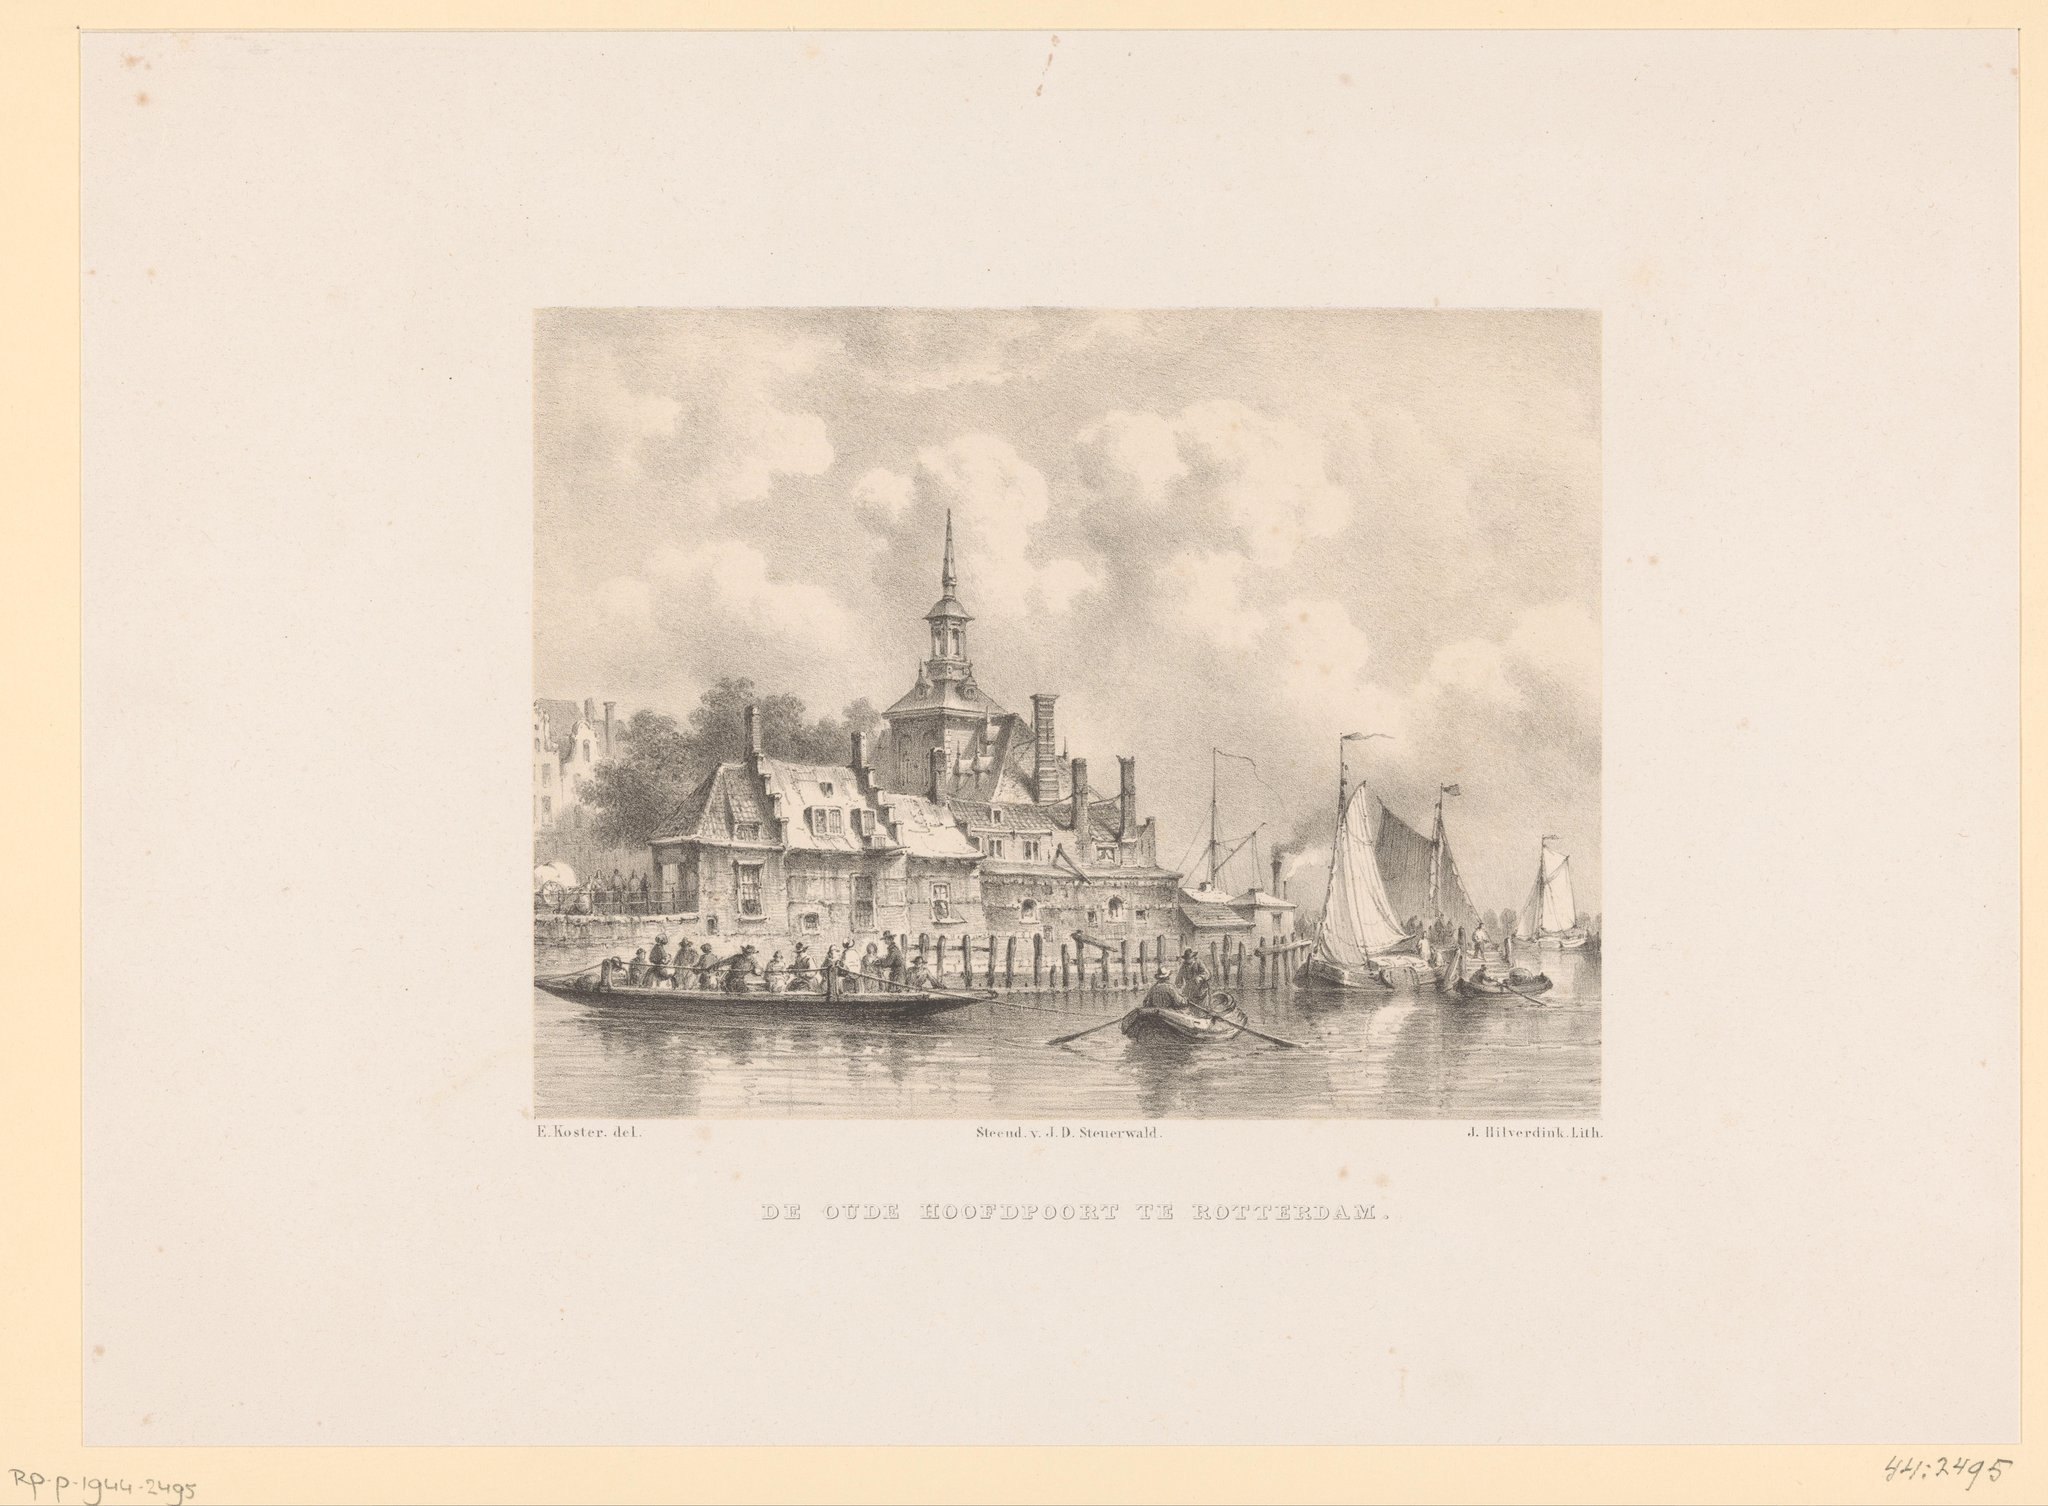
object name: print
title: Gezicht op de Ooster Oude Hoofdpoort in Rotterdam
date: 1858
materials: paper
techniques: tone lithography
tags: sailing-ship, sailing-boat, rowing-boat, canoe, etc., city-gate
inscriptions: collector's mark: Lugt 2228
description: Prent uit: Koster, Everhardus. E. Koster's schetsboek: Nederlandsche Stads- en Havengezichten (...). Amsterdam: Frans Buffa & Zn., 1858.